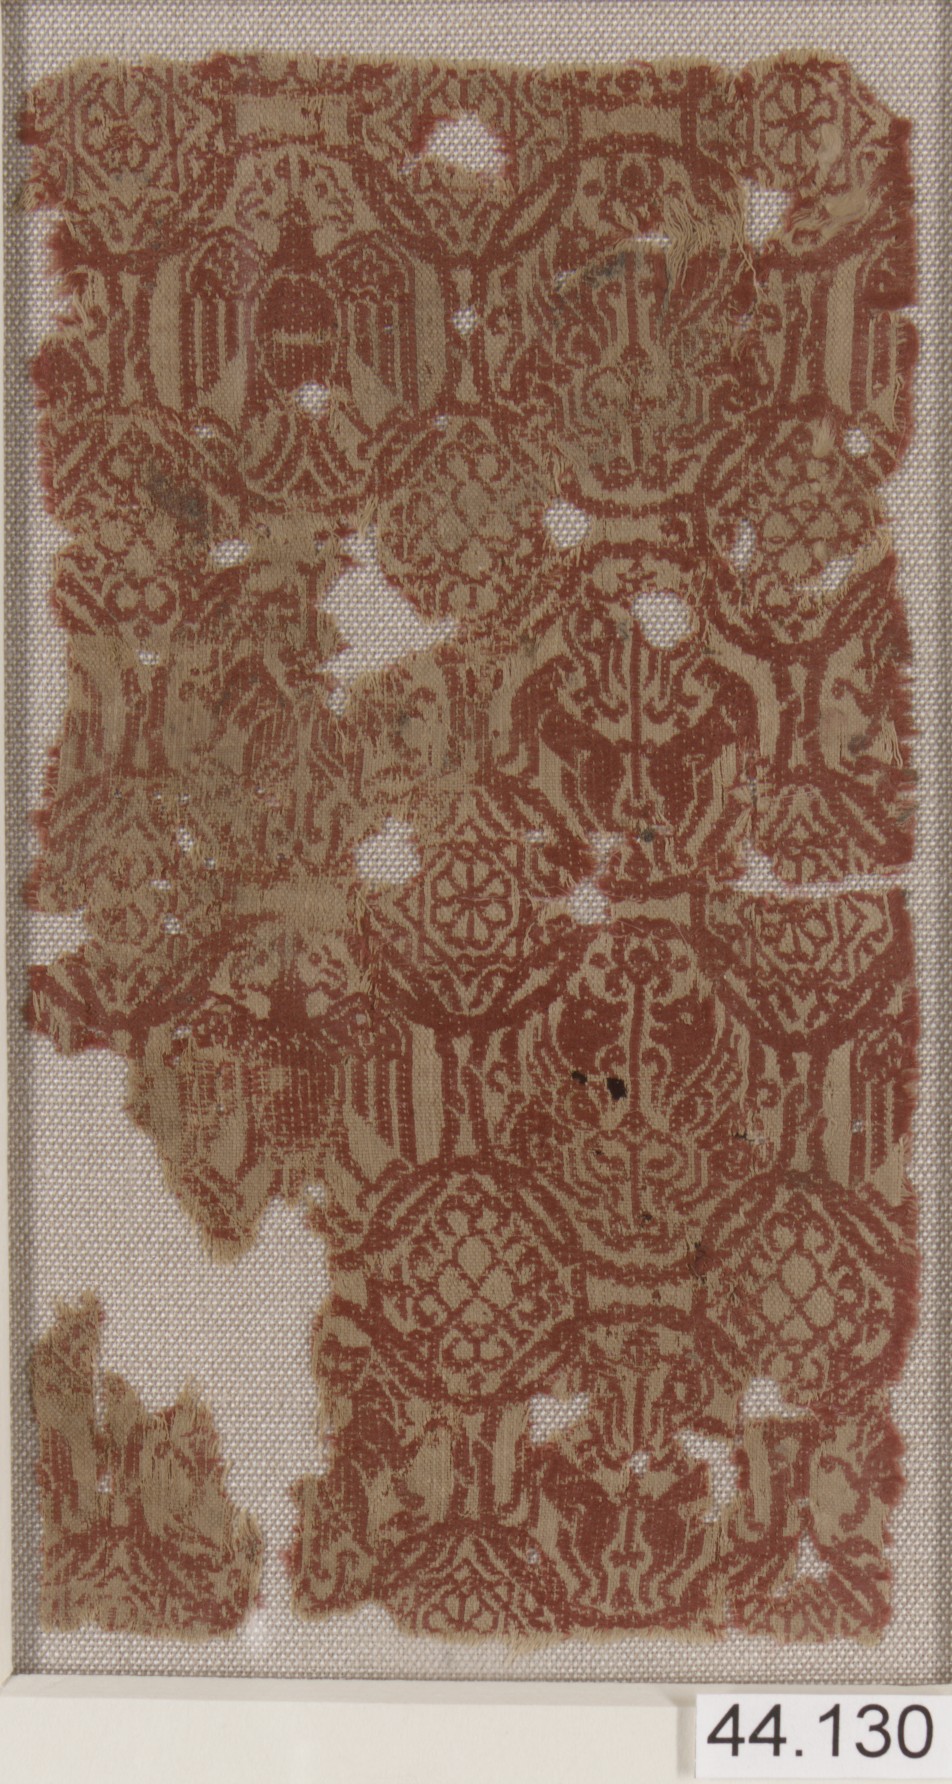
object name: textile fragment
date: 1201-1300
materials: silk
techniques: tapestry, weave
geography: spain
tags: eagles